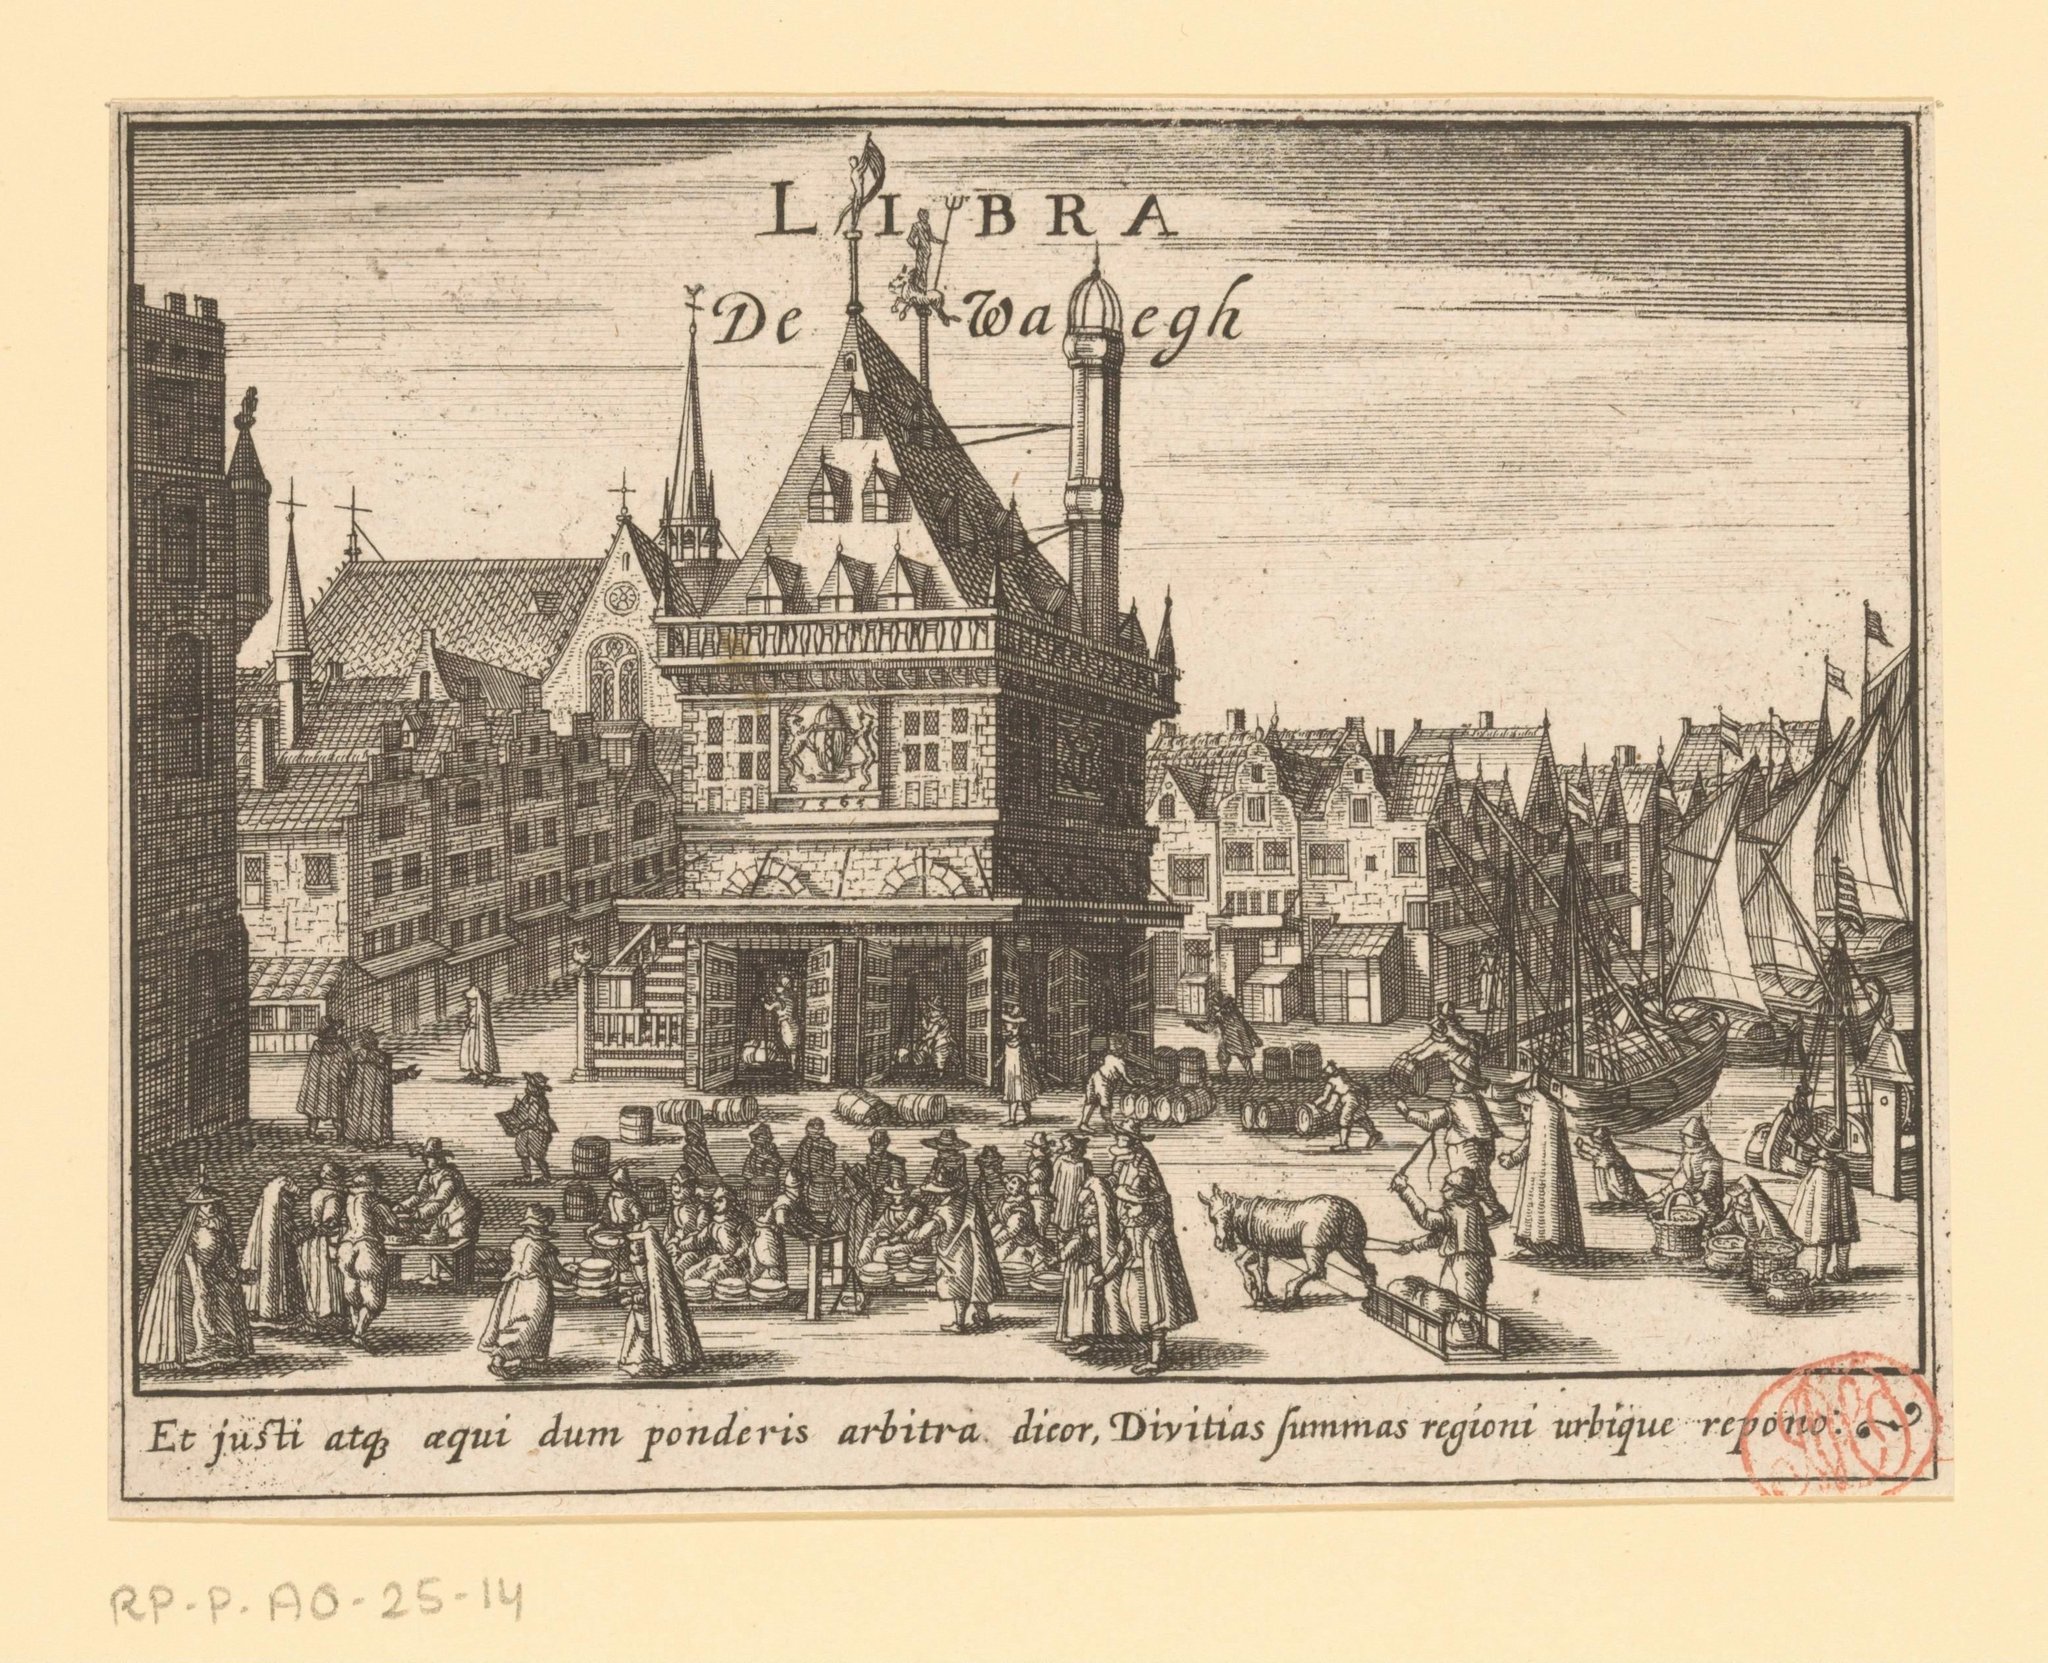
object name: print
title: Gezicht op de Waag op de Dam te Amsterdam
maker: Anonymous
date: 1611-1650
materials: paper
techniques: engraving, etching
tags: church (exterior), market, weigh-house, village square, place (+ city(-scape) with figures, staffage)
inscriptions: collector's mark: Lugt 195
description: Kopie naar prent gebruikt in: Pontanus, Johannes Isacius. Rerum et urbis Amstelodamensium Historia (…). Amsterdam: Jodocus Hondius I, 1611. En in: Pontanus, Johannes Isacius en Petrus Montanus. Historische beschrijvinghe der seer wijt beroemde coop-stadt Amsterdam (…). Amsterdam: Jocodus Hondius II, 1614.